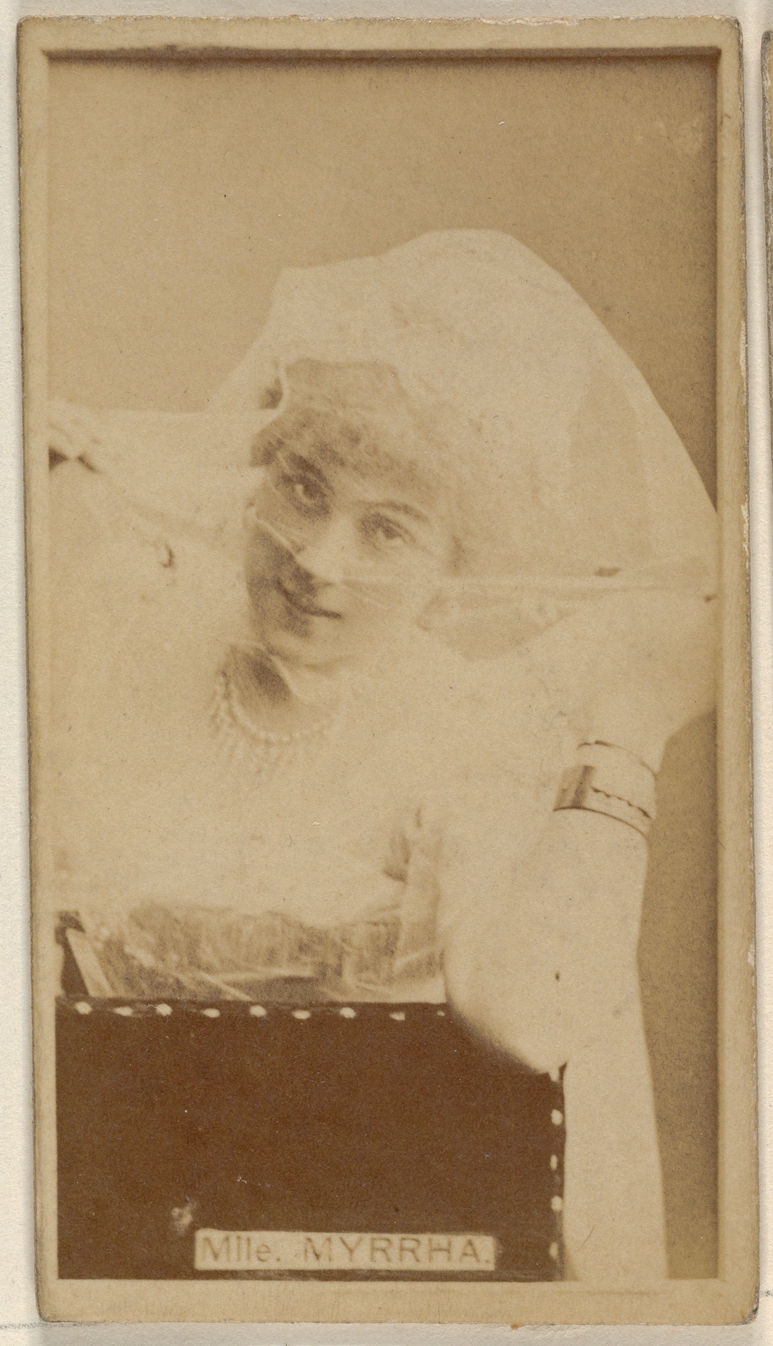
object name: photograph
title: Mlle. Myrrha, from the Actors and Actresses series (N45, Type 8) for Virginia Brights Cigarettes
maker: allen & ginter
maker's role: publisher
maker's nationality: american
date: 1888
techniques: albumen silver print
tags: portraits,women,actresses